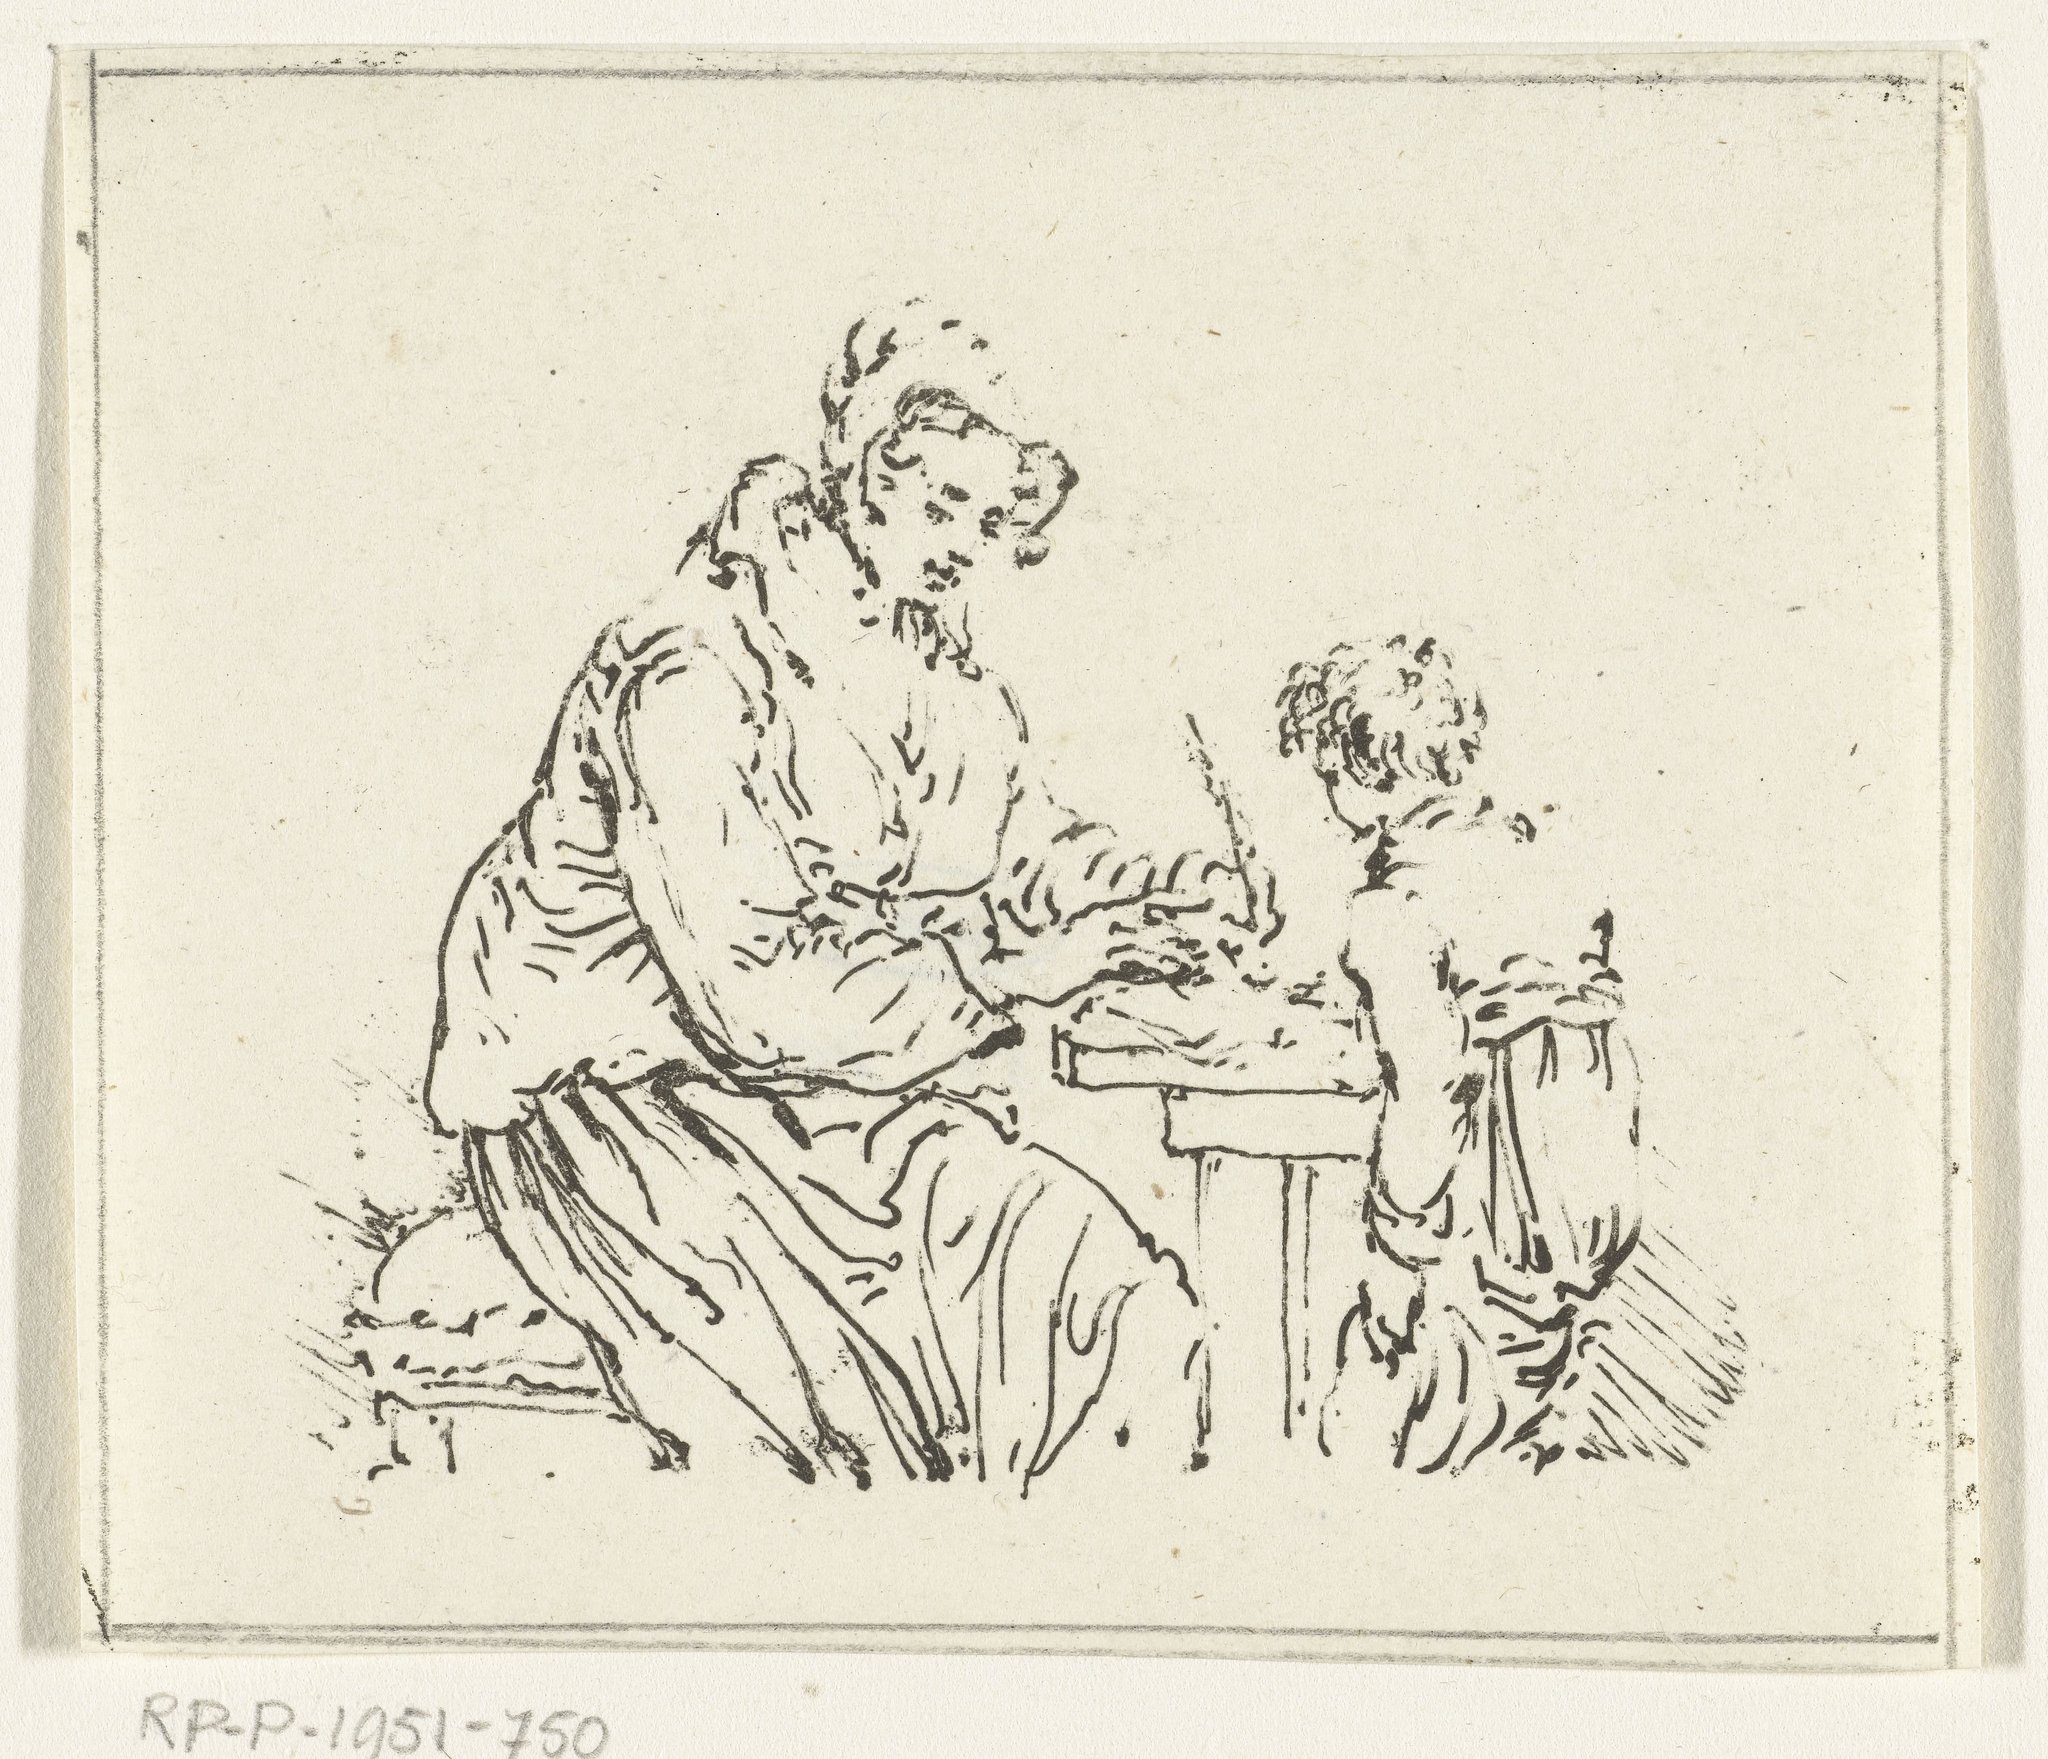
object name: print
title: Schrijvende vrouw en staande jongen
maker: pieter barbiers (iv)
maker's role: painter, print maker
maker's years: 1798-1848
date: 1808-1848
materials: paper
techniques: soft ground etching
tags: handwriting, writing as activity, child, mother and baby or young child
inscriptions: collector's mark: Lugt 2228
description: Een vrouw zit schrijvend aan tafel, waarbij een staande jongen